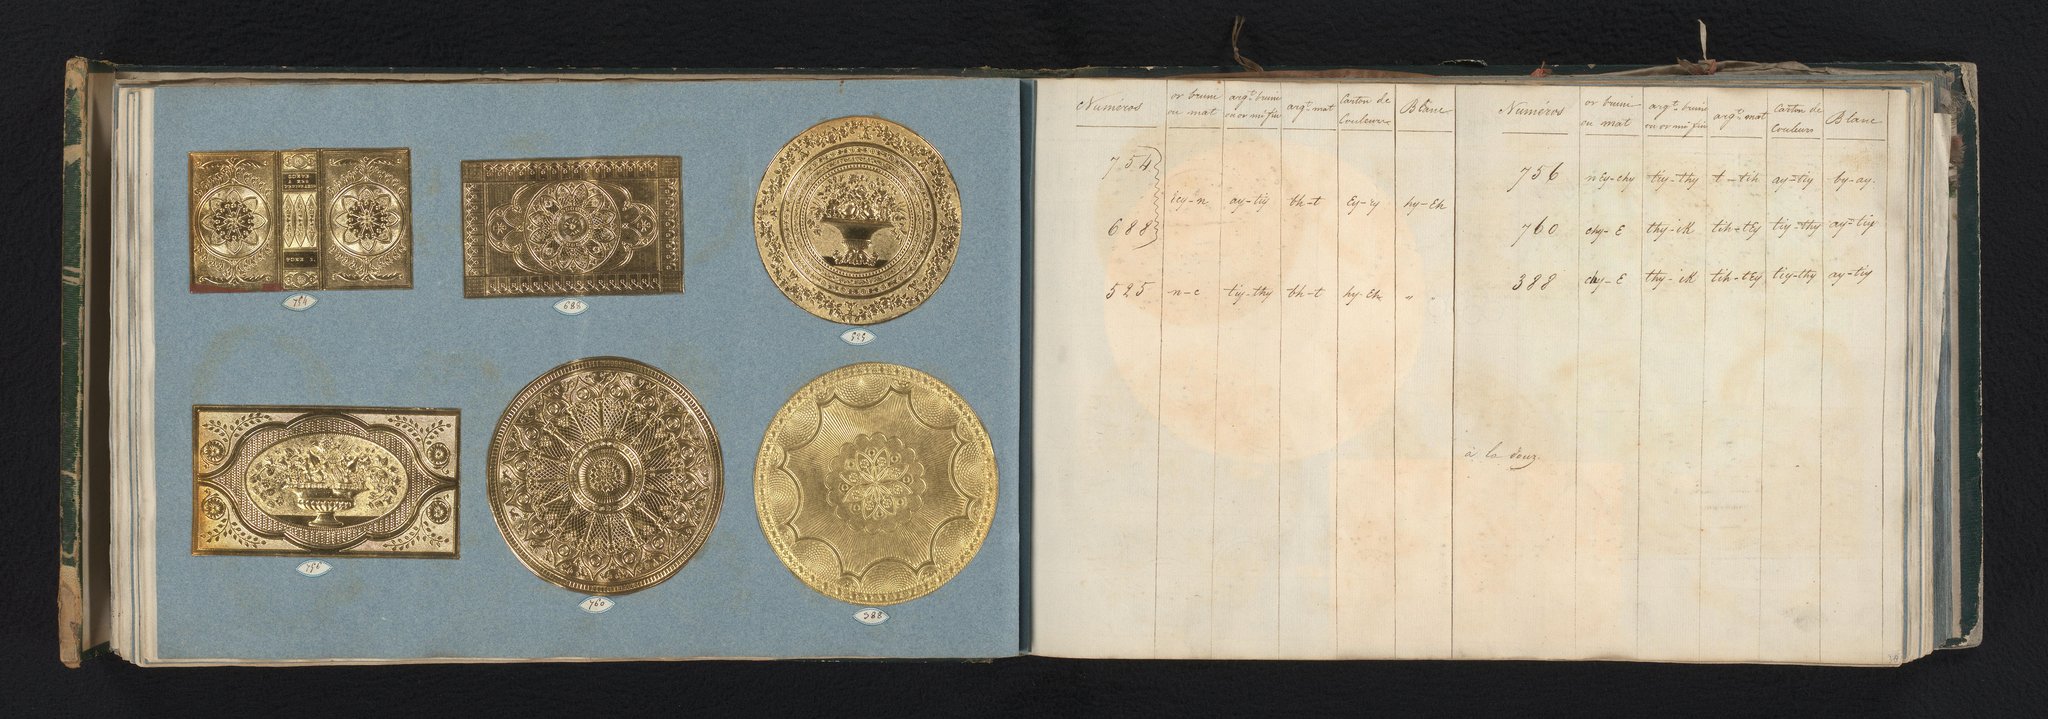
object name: metallic paper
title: Twee bladzijden met stalen van vignetten van goudkleurig metaalpapier en bijbehorend tabel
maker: Anonymous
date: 1830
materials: gold leaf, ink, paper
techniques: manufacturing, writing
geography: france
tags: ornaments ~ art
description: Twee bladzijden met links 6 opgeplakte en met etiketten genummerde (754-388) stalen van afzonderlijke vignetten en emblemen van goudkleurig metaalpapier. Op de tegenoverliggende rechterbladzijde een tabel met de handgeschreven corresponderende specificaties (in code) per ornament. Onderdeel van het stalenboek geschonken door de dames Van Rijn, vermoedelijk van een Franse papierfabrikant van luxe papieren, of diens vertegenwoordiger in Nederland, ca. 1830.